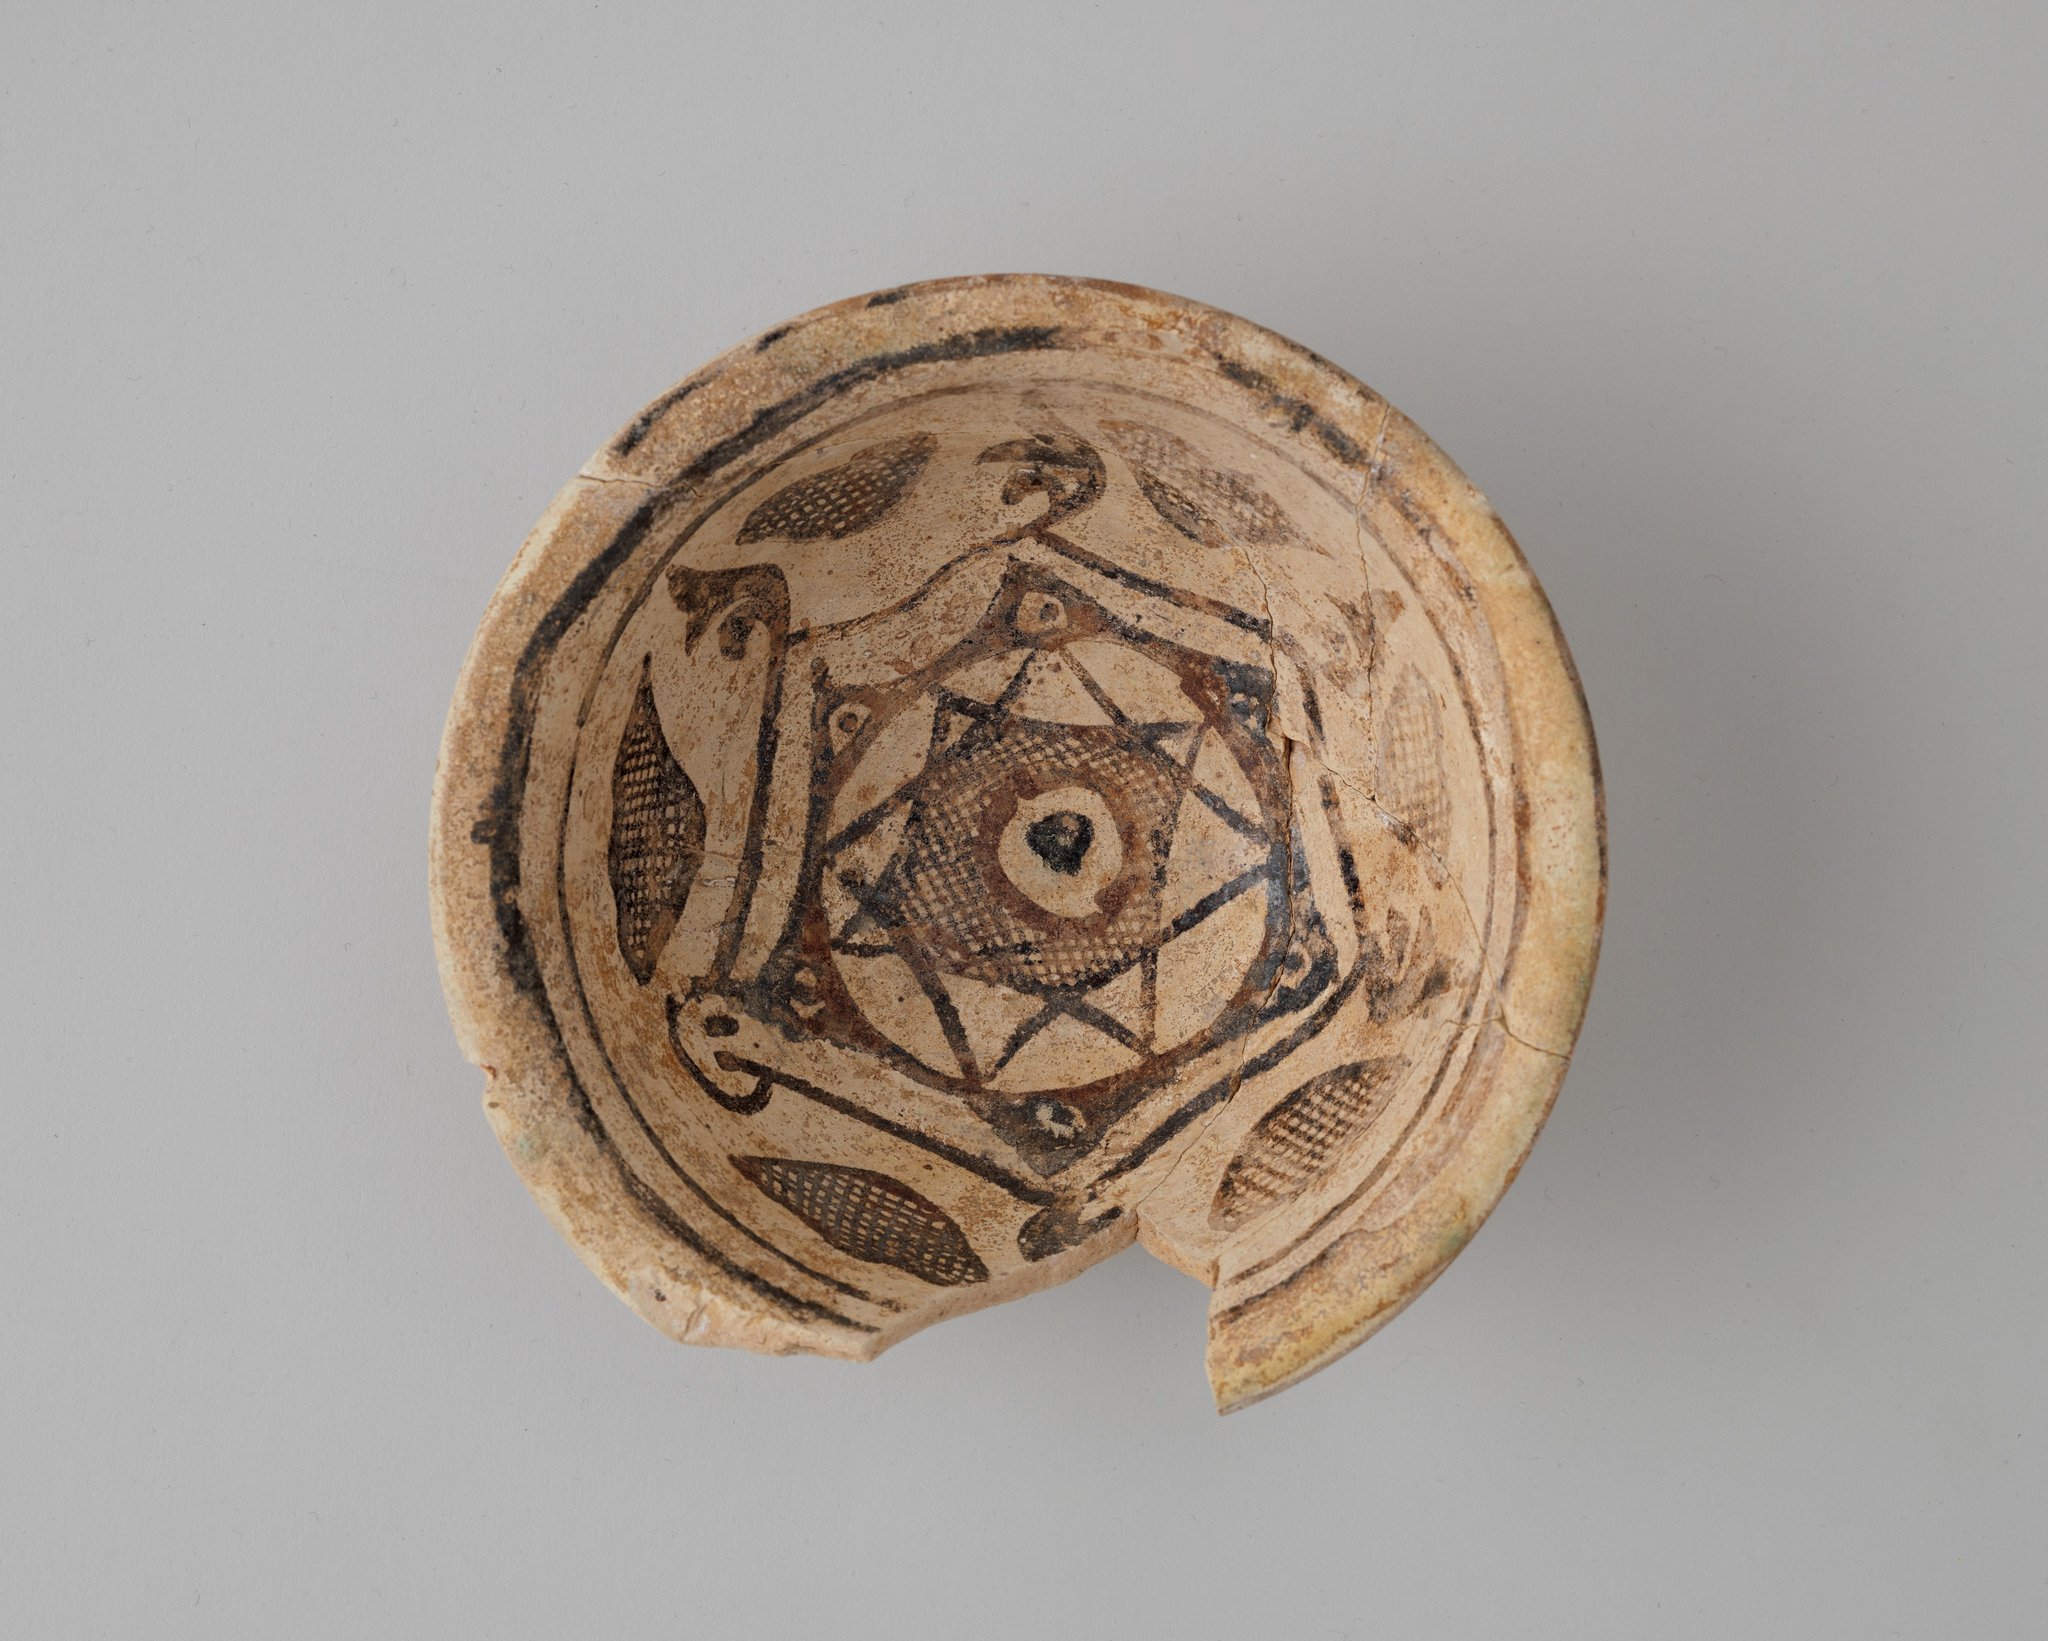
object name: bowl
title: Bowl with Eight-Pointed Star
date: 767-900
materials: earthenware, glaze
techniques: polychrome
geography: iran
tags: stars